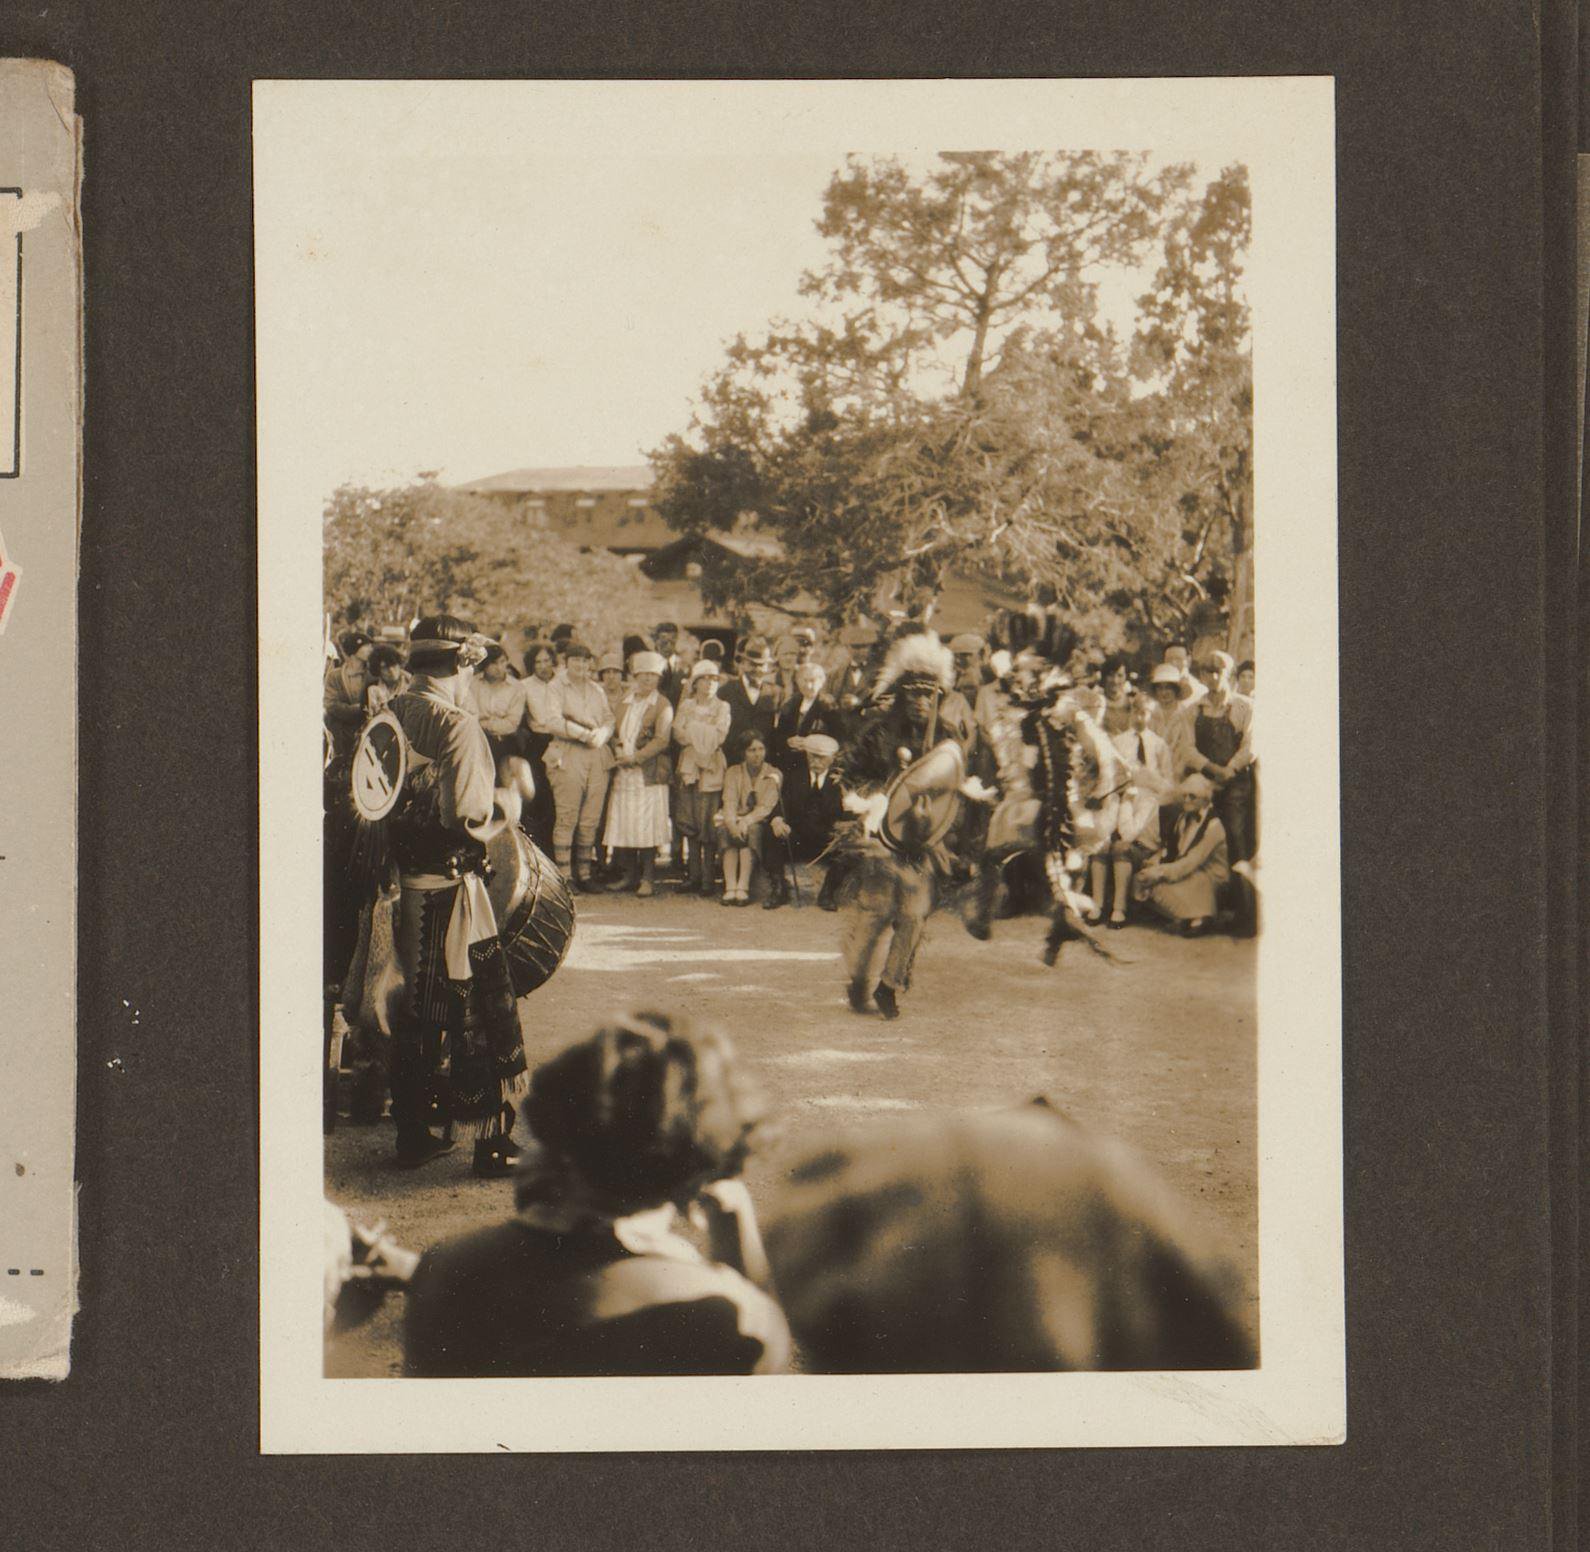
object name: photograph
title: Dans, uitgevoerd door oorspronkelijke bevolking van Noord Amerika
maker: Anonymous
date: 1928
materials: photographic support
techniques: gelatin silver print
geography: united states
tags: ritual practices ~ american indian religions, indigenous peoples of north america, group dancing, united states of america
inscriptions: annotation: ‘Grand Canyon’, annotation: ‘Indiaansche dansen’